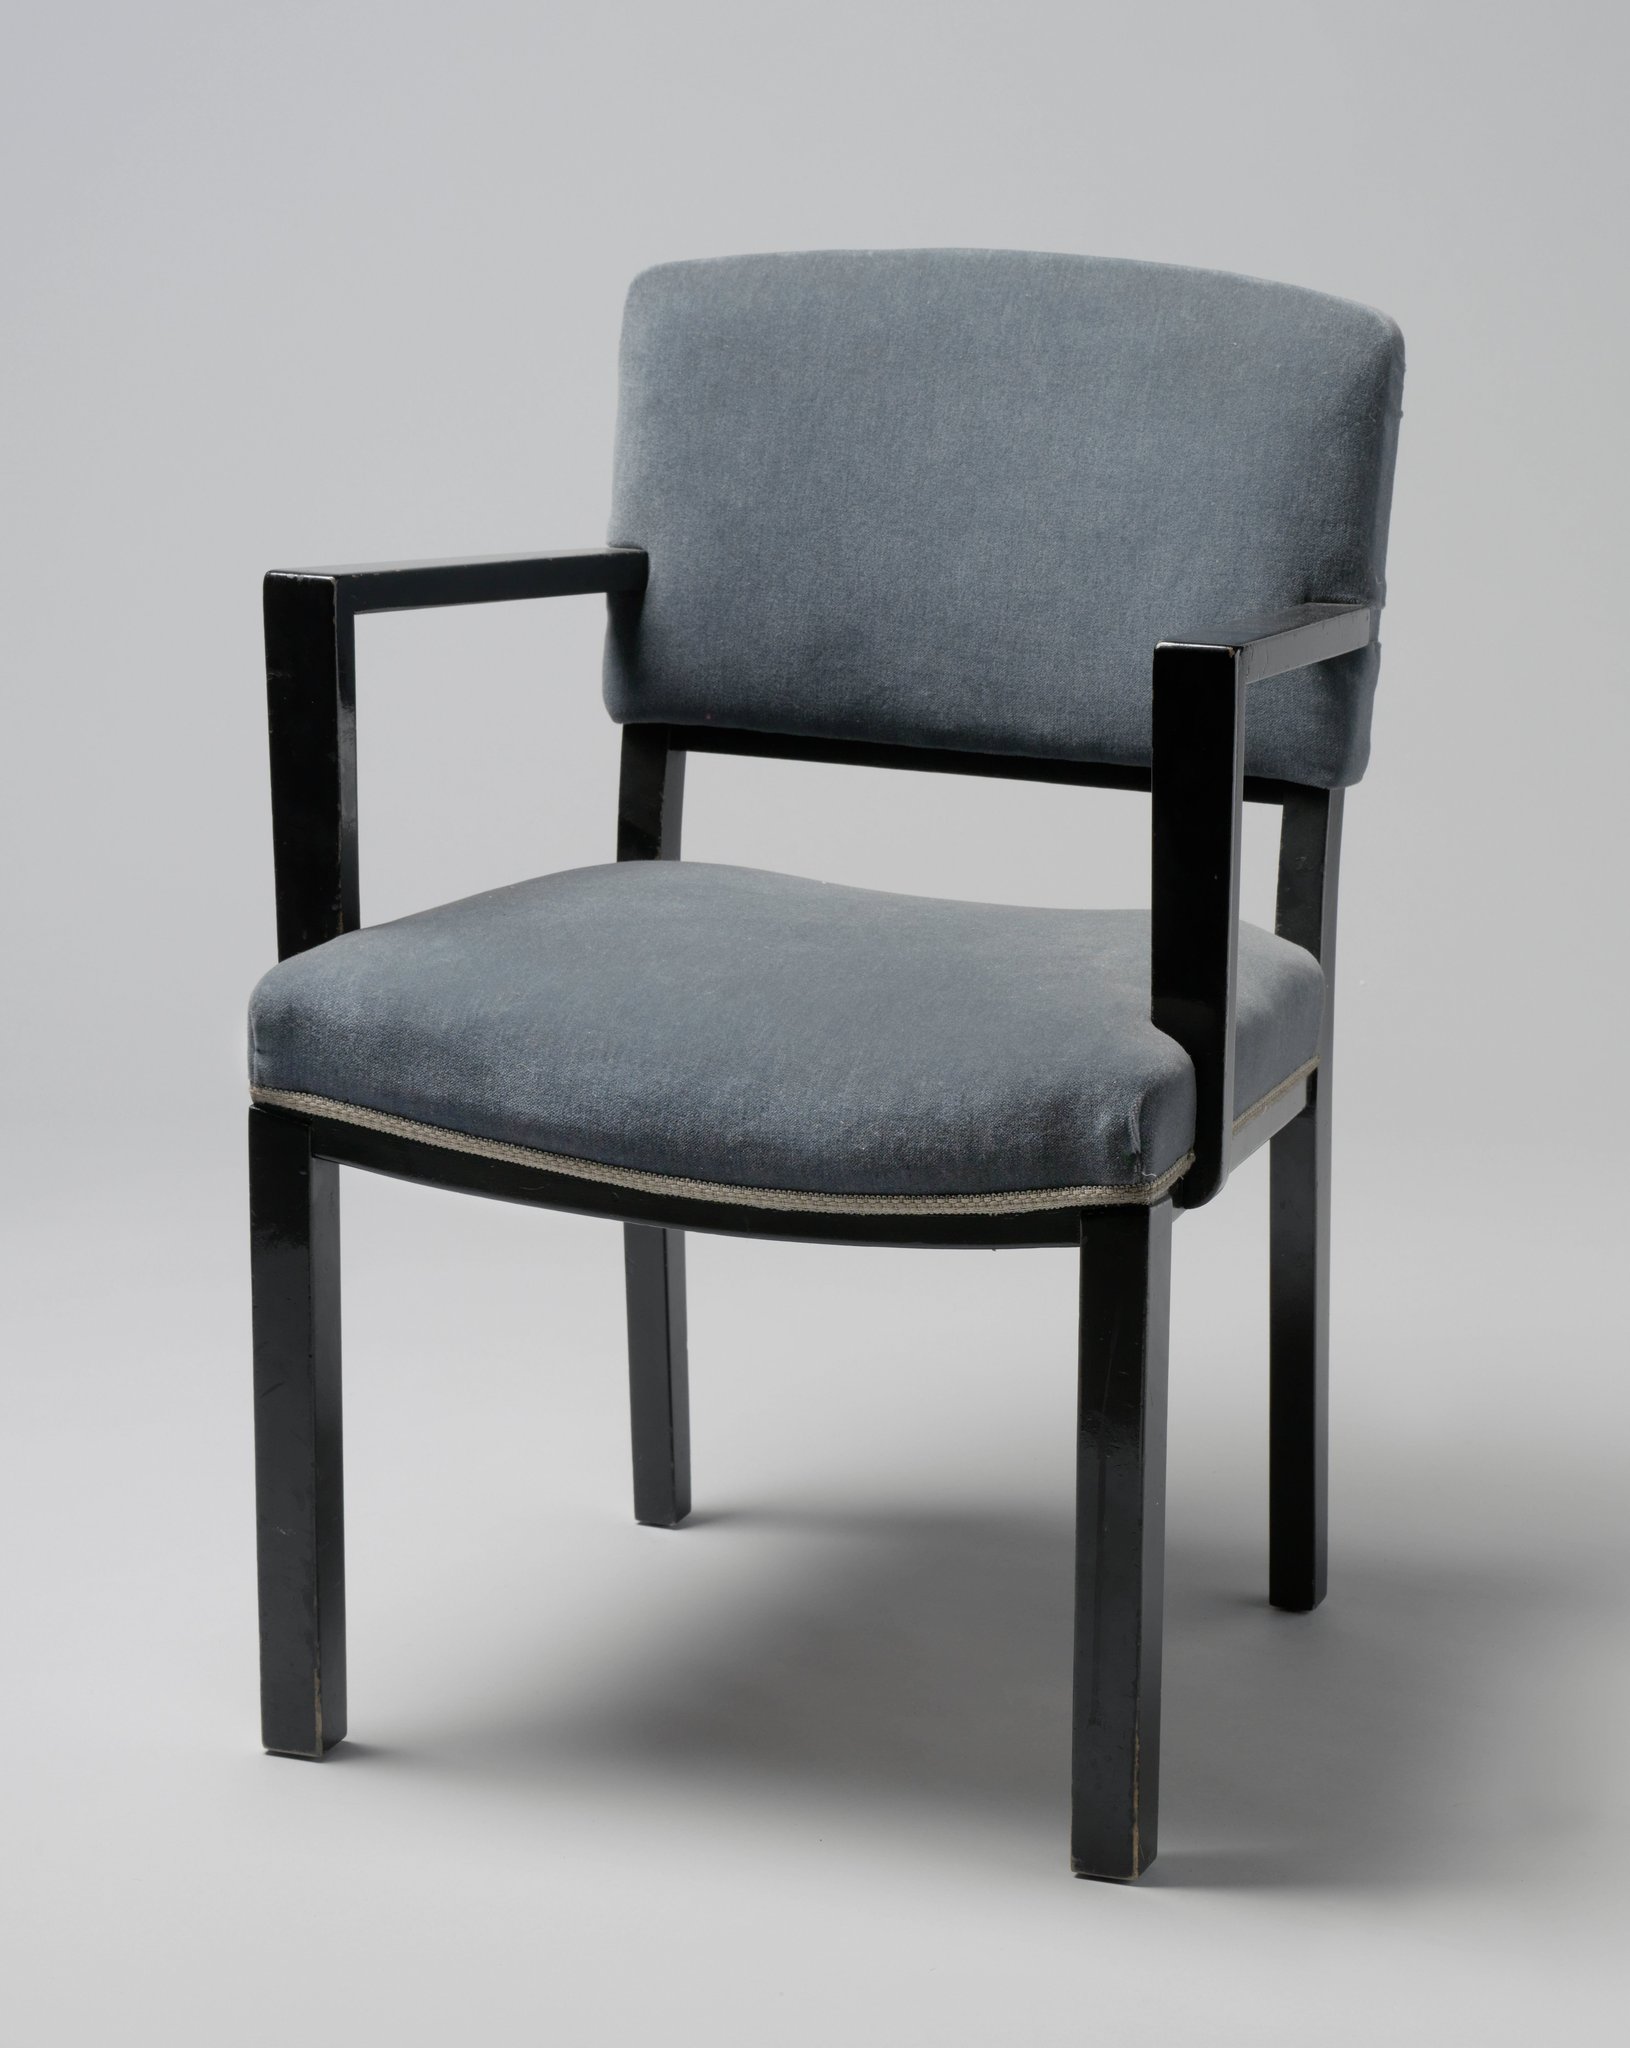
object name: furniture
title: Armstoel met hoekige armleggers en bekleed met blauwe trijp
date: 1933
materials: textile, wood, wool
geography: the hague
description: Armstoel van zwart gelakt hout rustend op vier vierkante poten. De voorpoten zijn recht en de achterpoten zijn licht gebogen en lopen door in de rugstijlen. De zitting is gevat in vier regels waarvan de twee zijregels recht zijn en de voor- en achterregel gebogen. De onderdorpel van de rugleuning is ook gebogen. Vanaf het midden van de rugleuning lopen platte hoekige armleggers af die aan de voorzijde, niet in het verlengde van de voorpoten, rusten op platte stutten die deels op en deels tegen de zitting zijn bevestigd. Zowel de leuning als de zitting is bekleed met blauwe trijp. De bekleding van de zitting is afgezet met een beige bies.